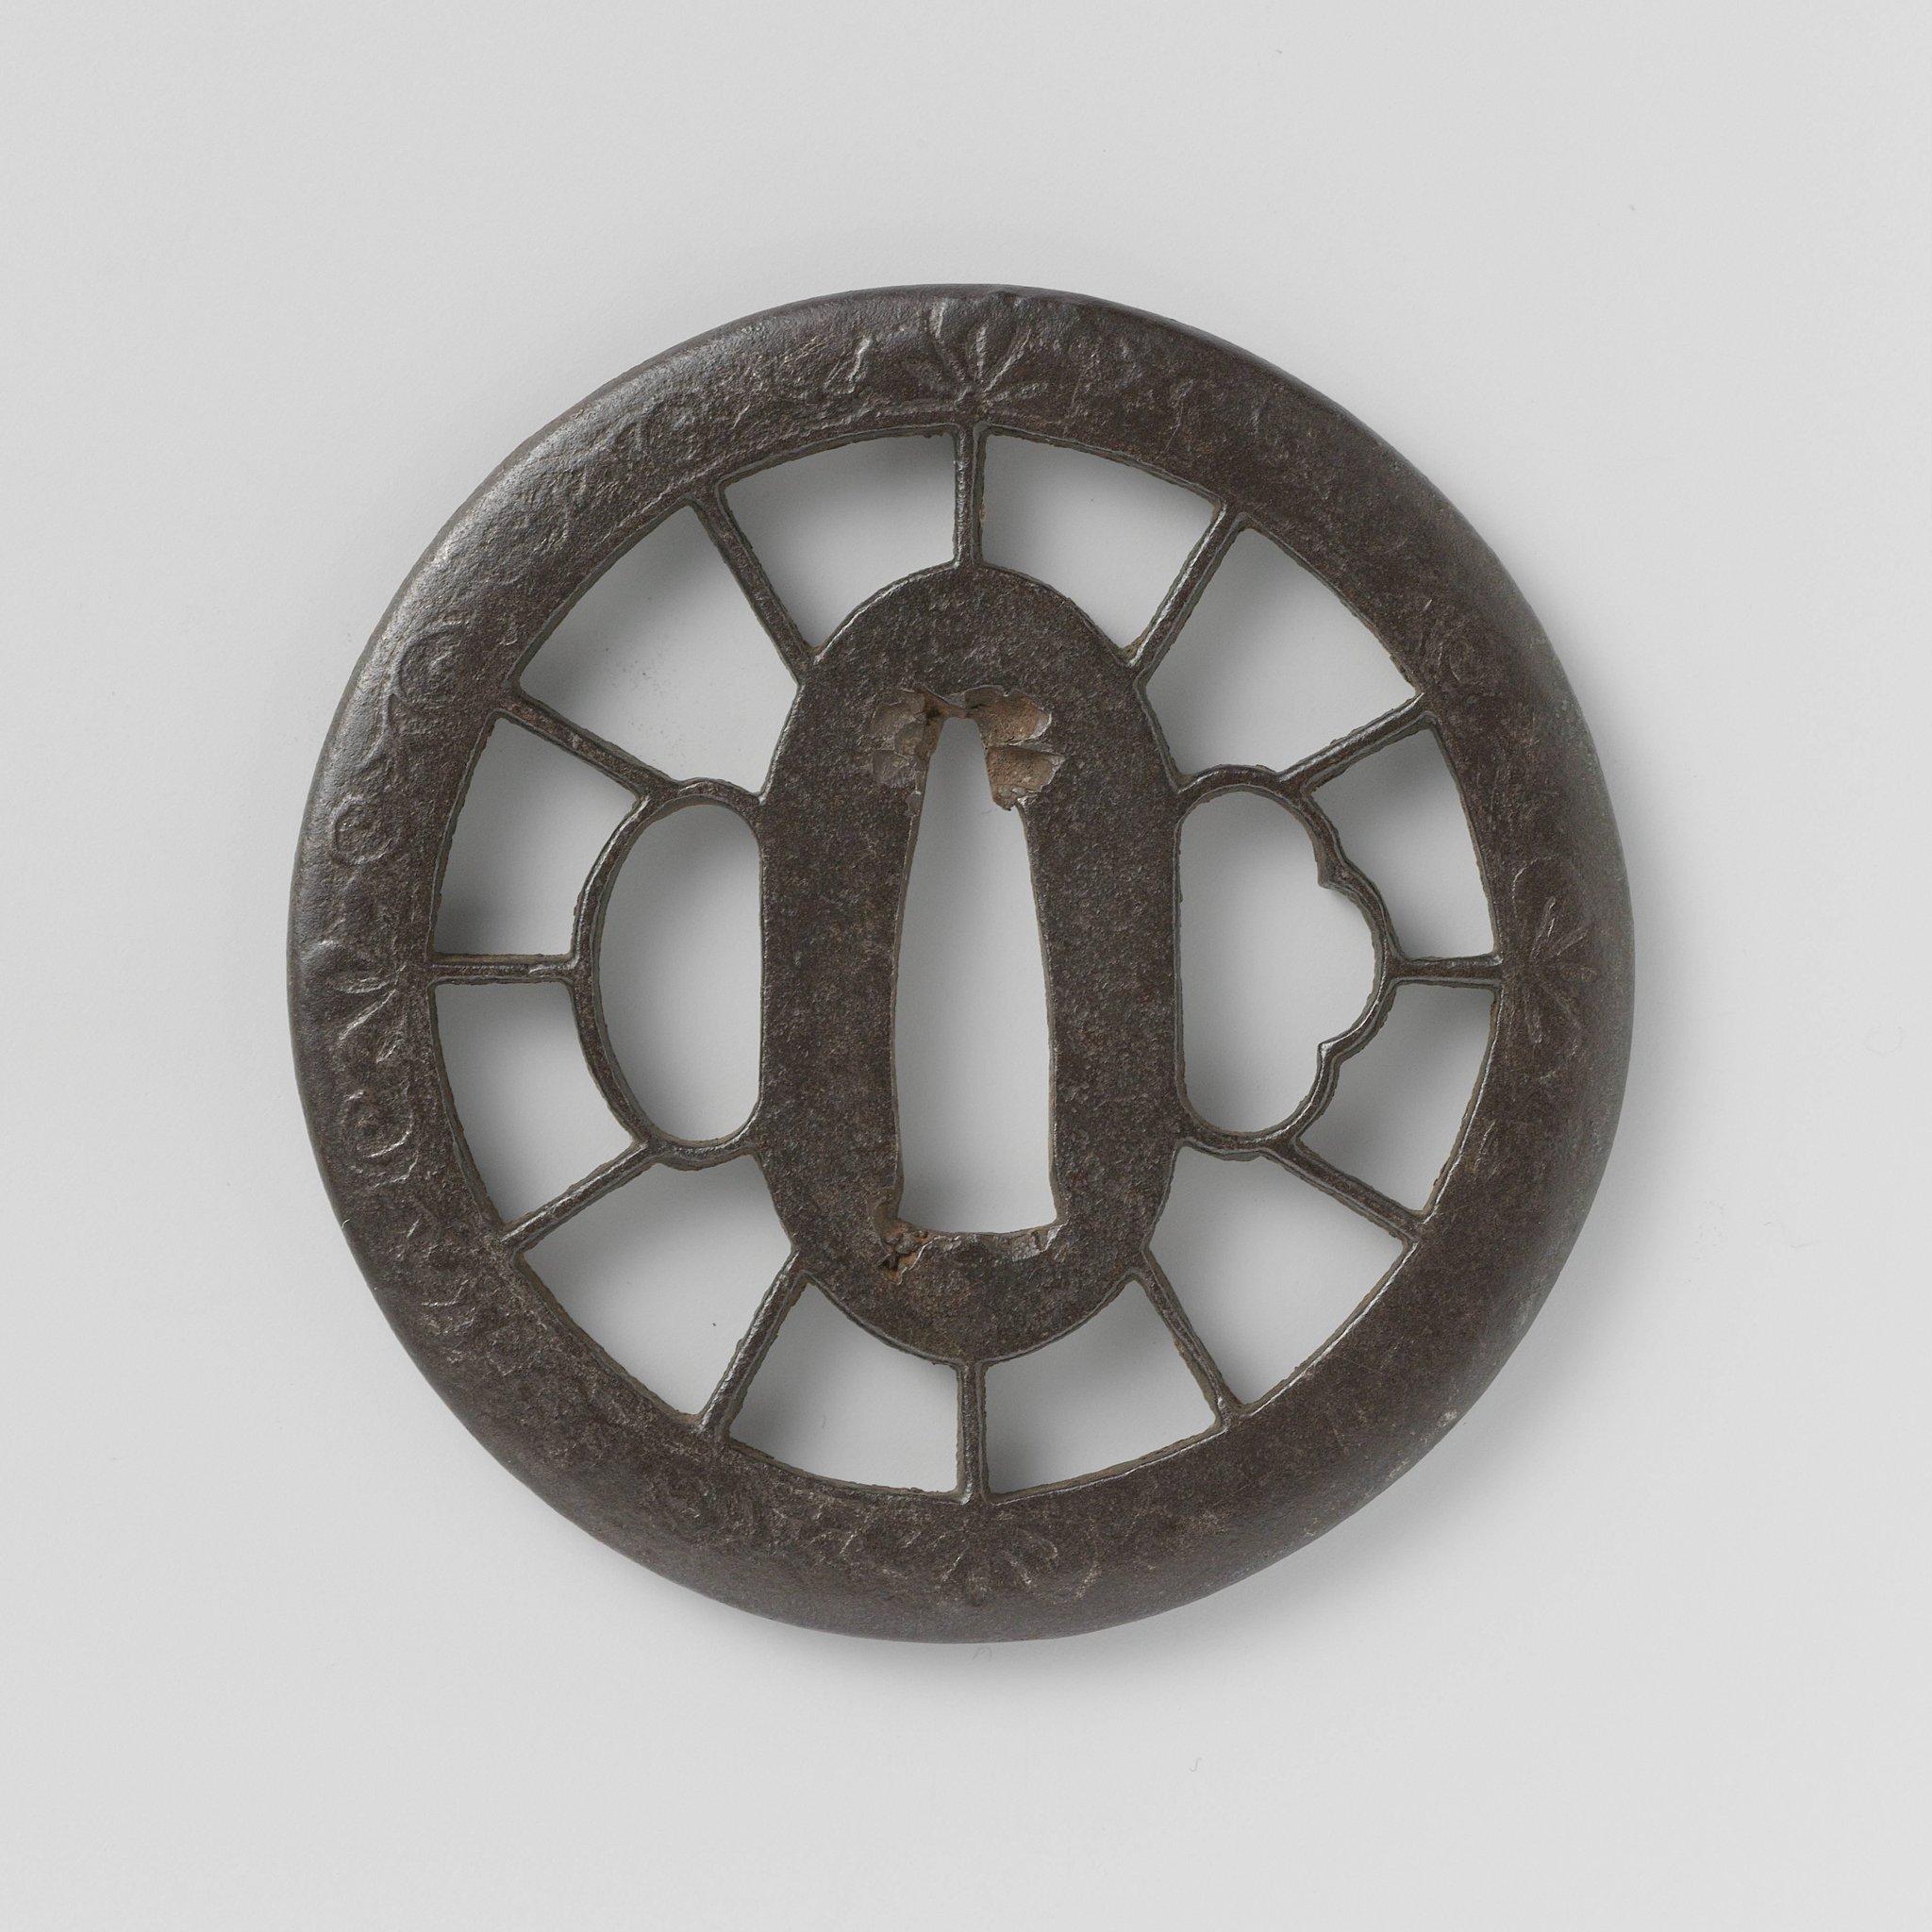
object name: tsuba, zwaardstootplaat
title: Hand guard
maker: Anonymous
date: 1600-1699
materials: iron, silver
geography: japan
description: Bijna ronde tsuba in de vorm van een wiel; op de rand een versiering in reliëf van gestileerde ranken en bladeren.